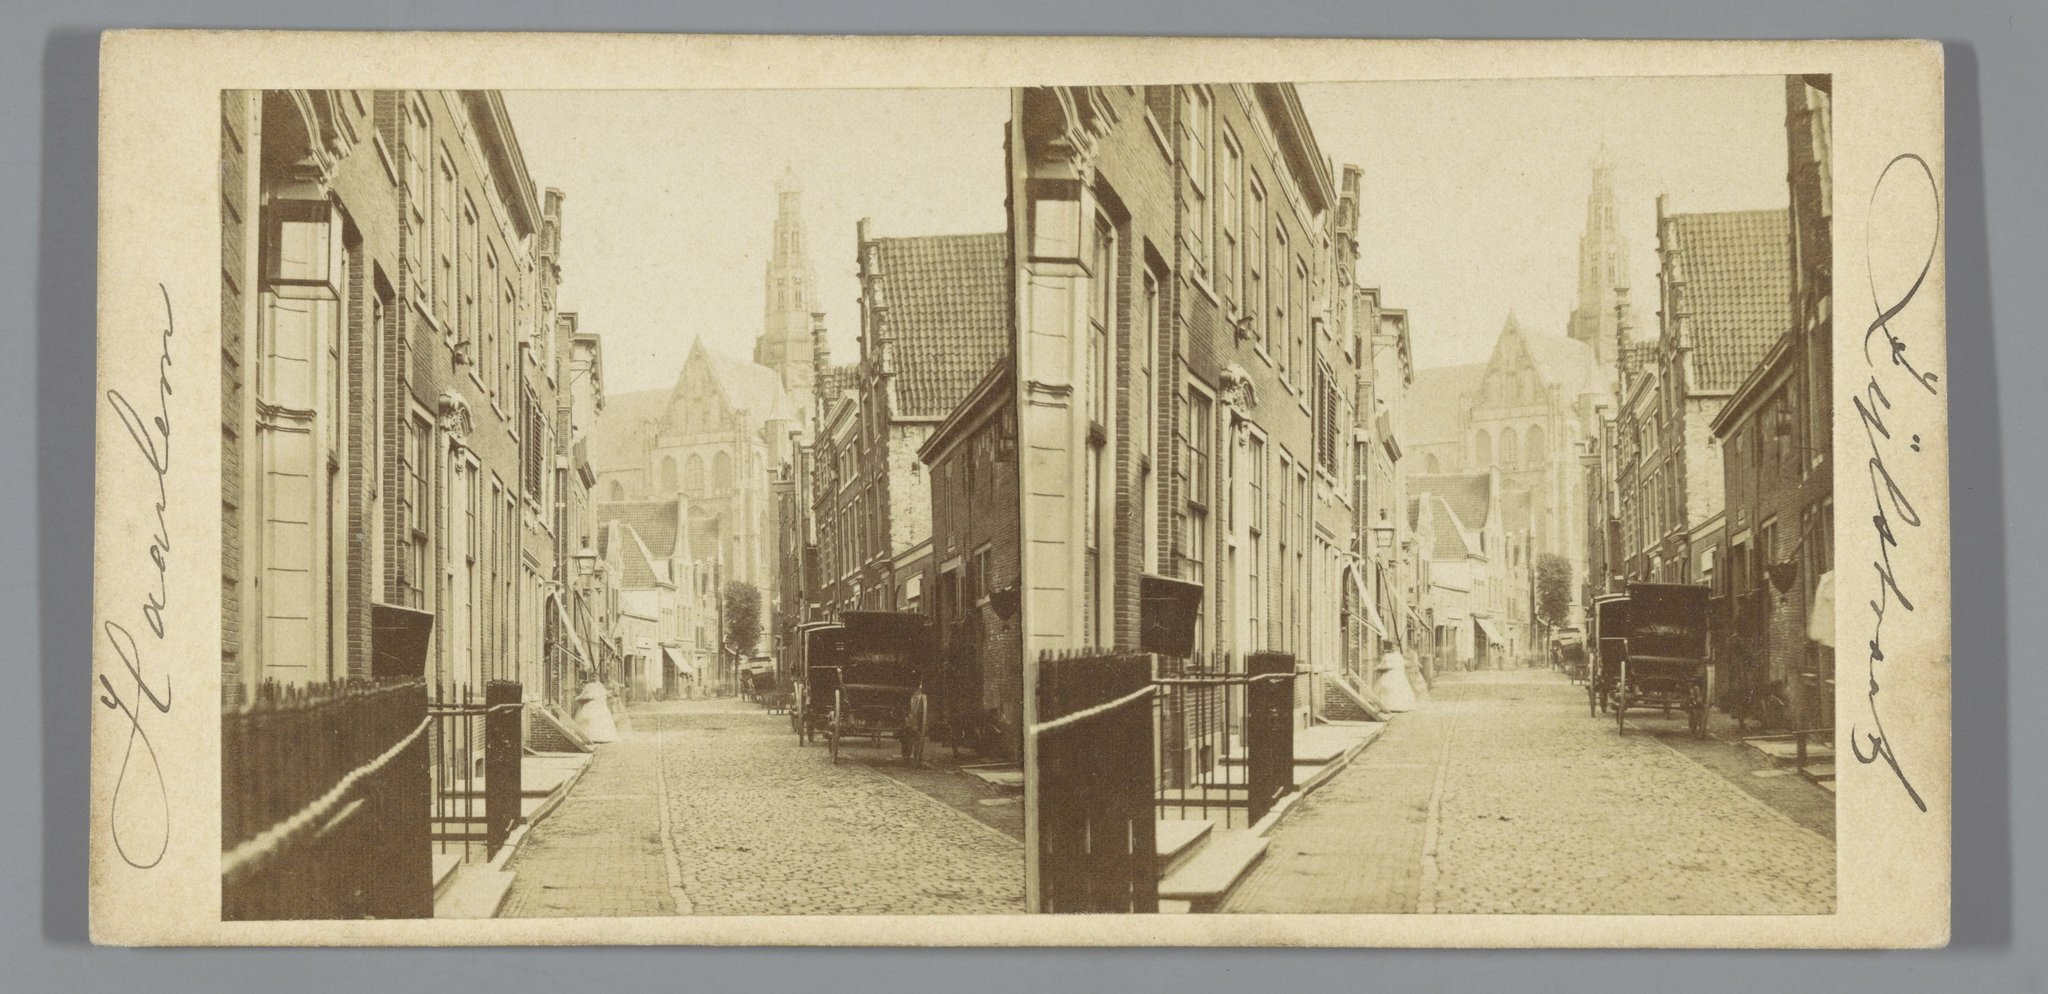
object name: stereograph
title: Smedestraat in Haarlem, gezien richting de Sint-Bavokerk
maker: pieter oosterhuis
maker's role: draughtsman, print maker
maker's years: 1816-1885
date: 1859-1865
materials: cardboard, paper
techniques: albumen print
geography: haarlem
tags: church (exterior), street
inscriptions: number: ‘54’, number: ‘2’, inscription: ‘P’, number: ‘No. 1’, inscription: ‘Haarlem/ Zijlstraat’